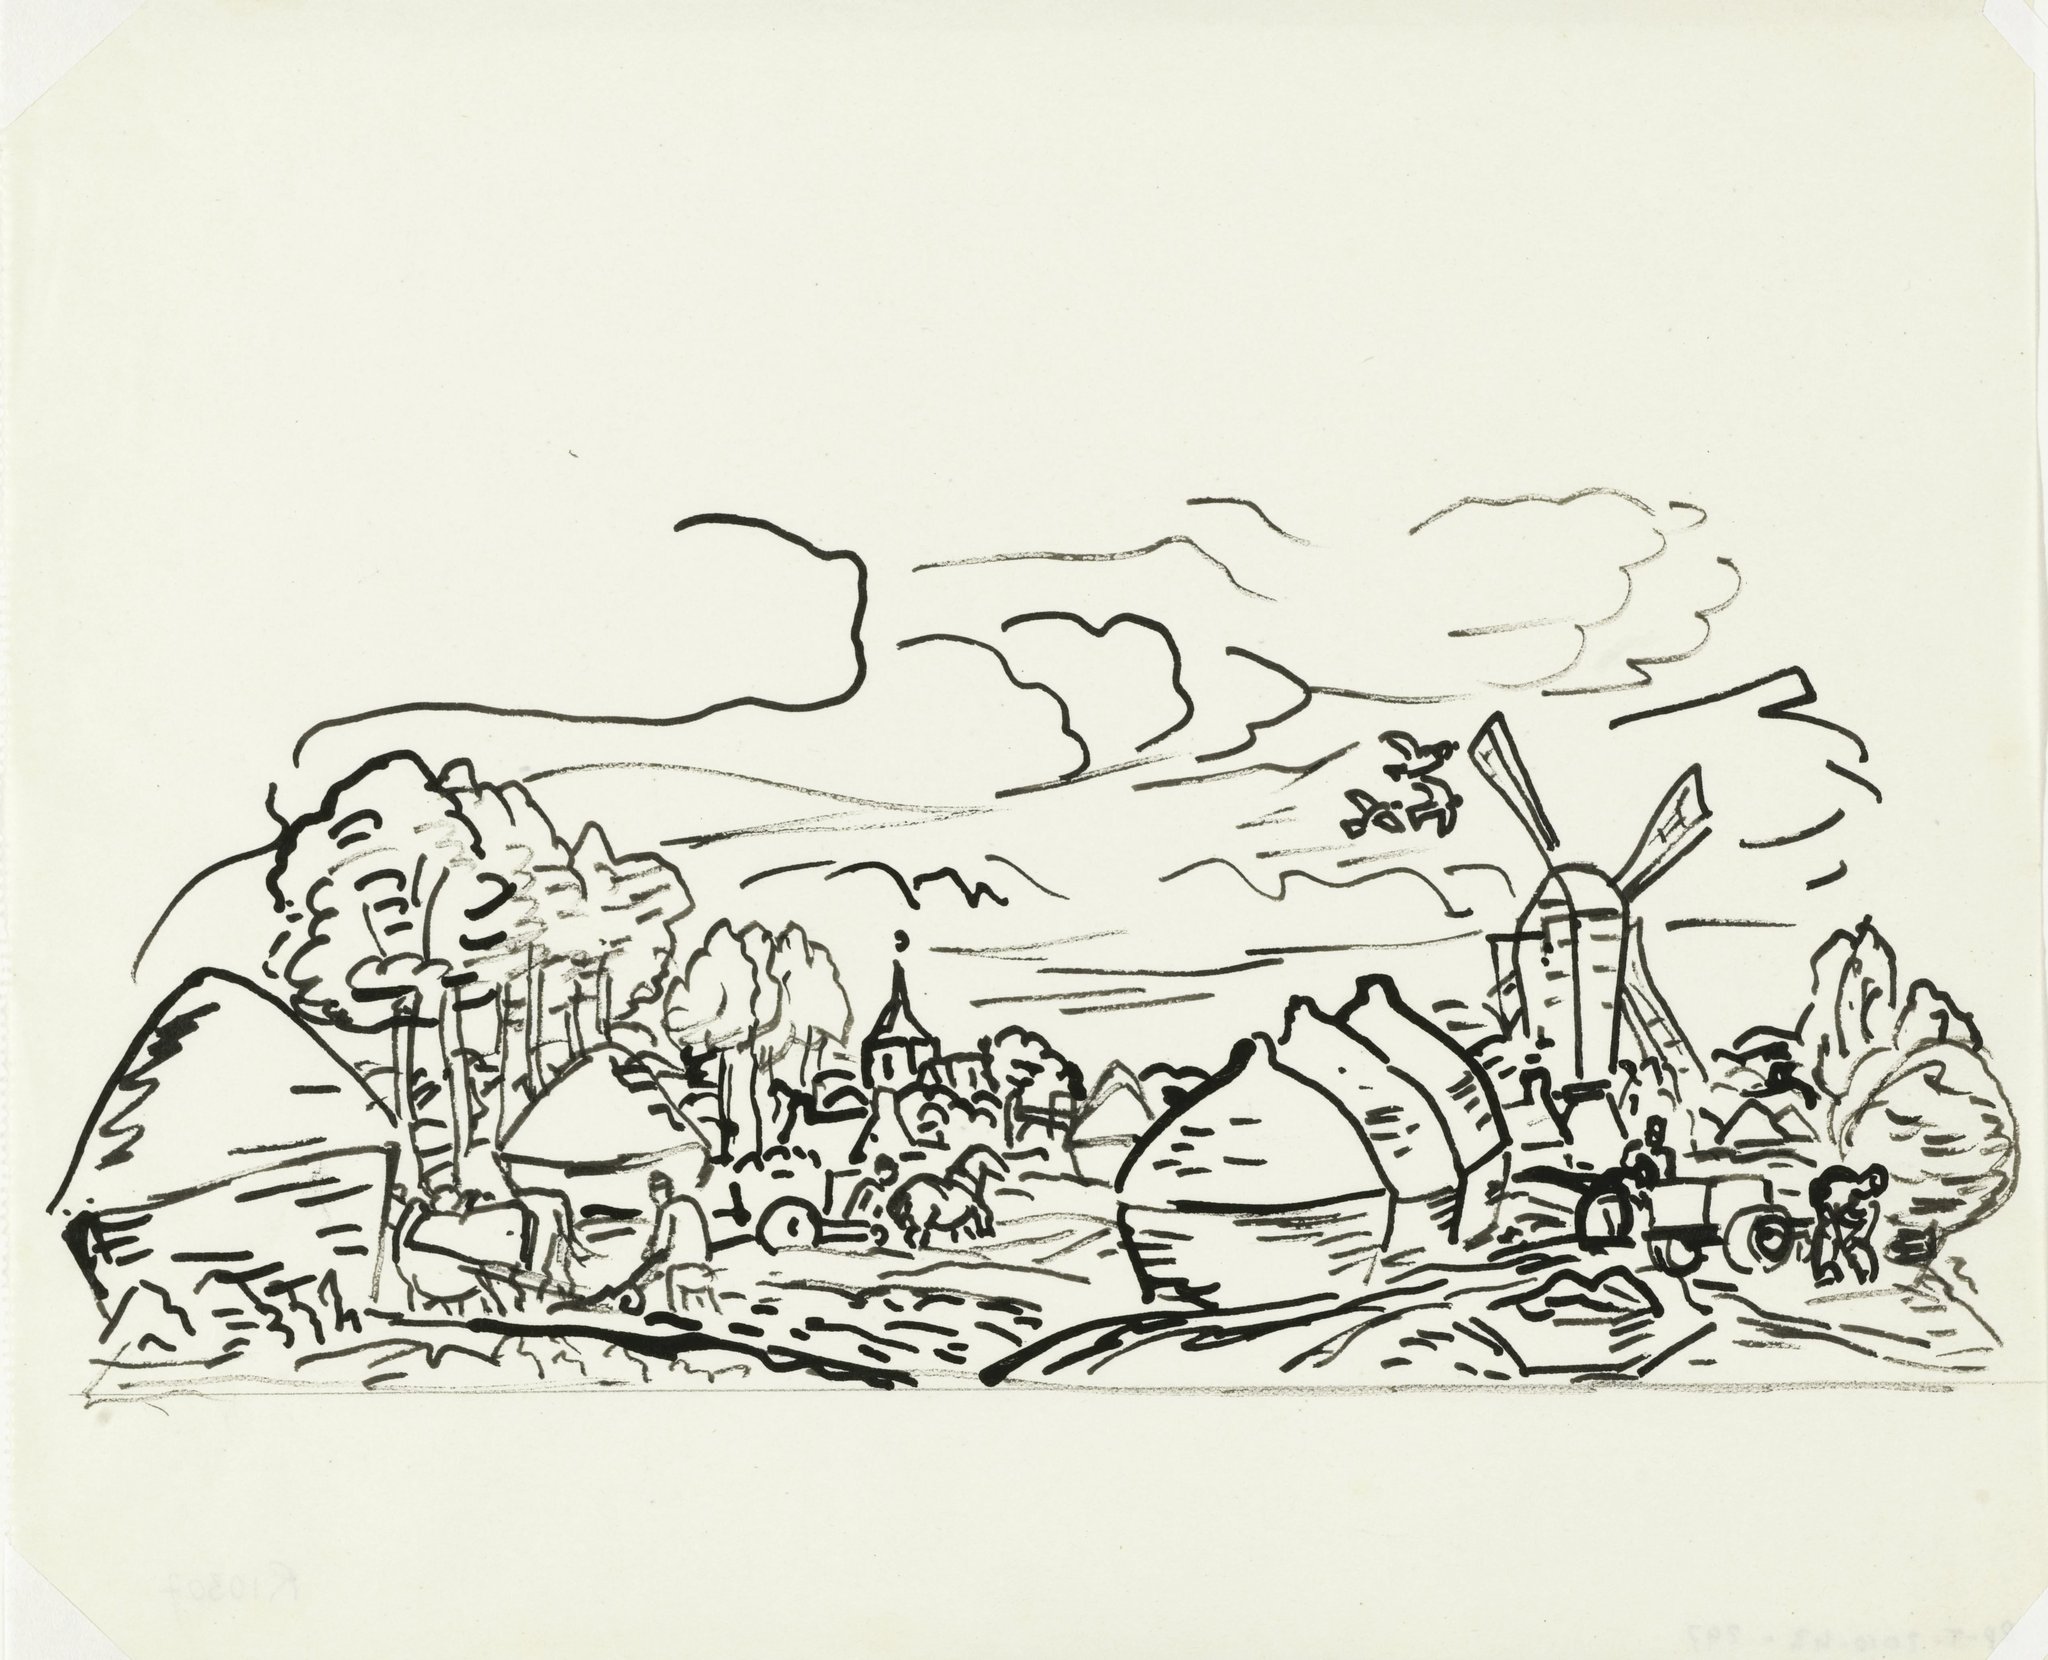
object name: drawing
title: Vignet voor biografie van Gestel door Prof. W. van der Pluym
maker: leo gestel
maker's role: draughtsman, print maker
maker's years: 1881-1941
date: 1935-1936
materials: ink, paper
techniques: brush, pen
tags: print maker, draughtsman, leo gestel, village, hay-stack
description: Landschap met hooimijten, molen, kerktoren, ploegende boer, boer met paard en wagen, rechtsonder boer op een traktor en een boer met spade in de hand, links van de molenwieken drie vogels in vlucht